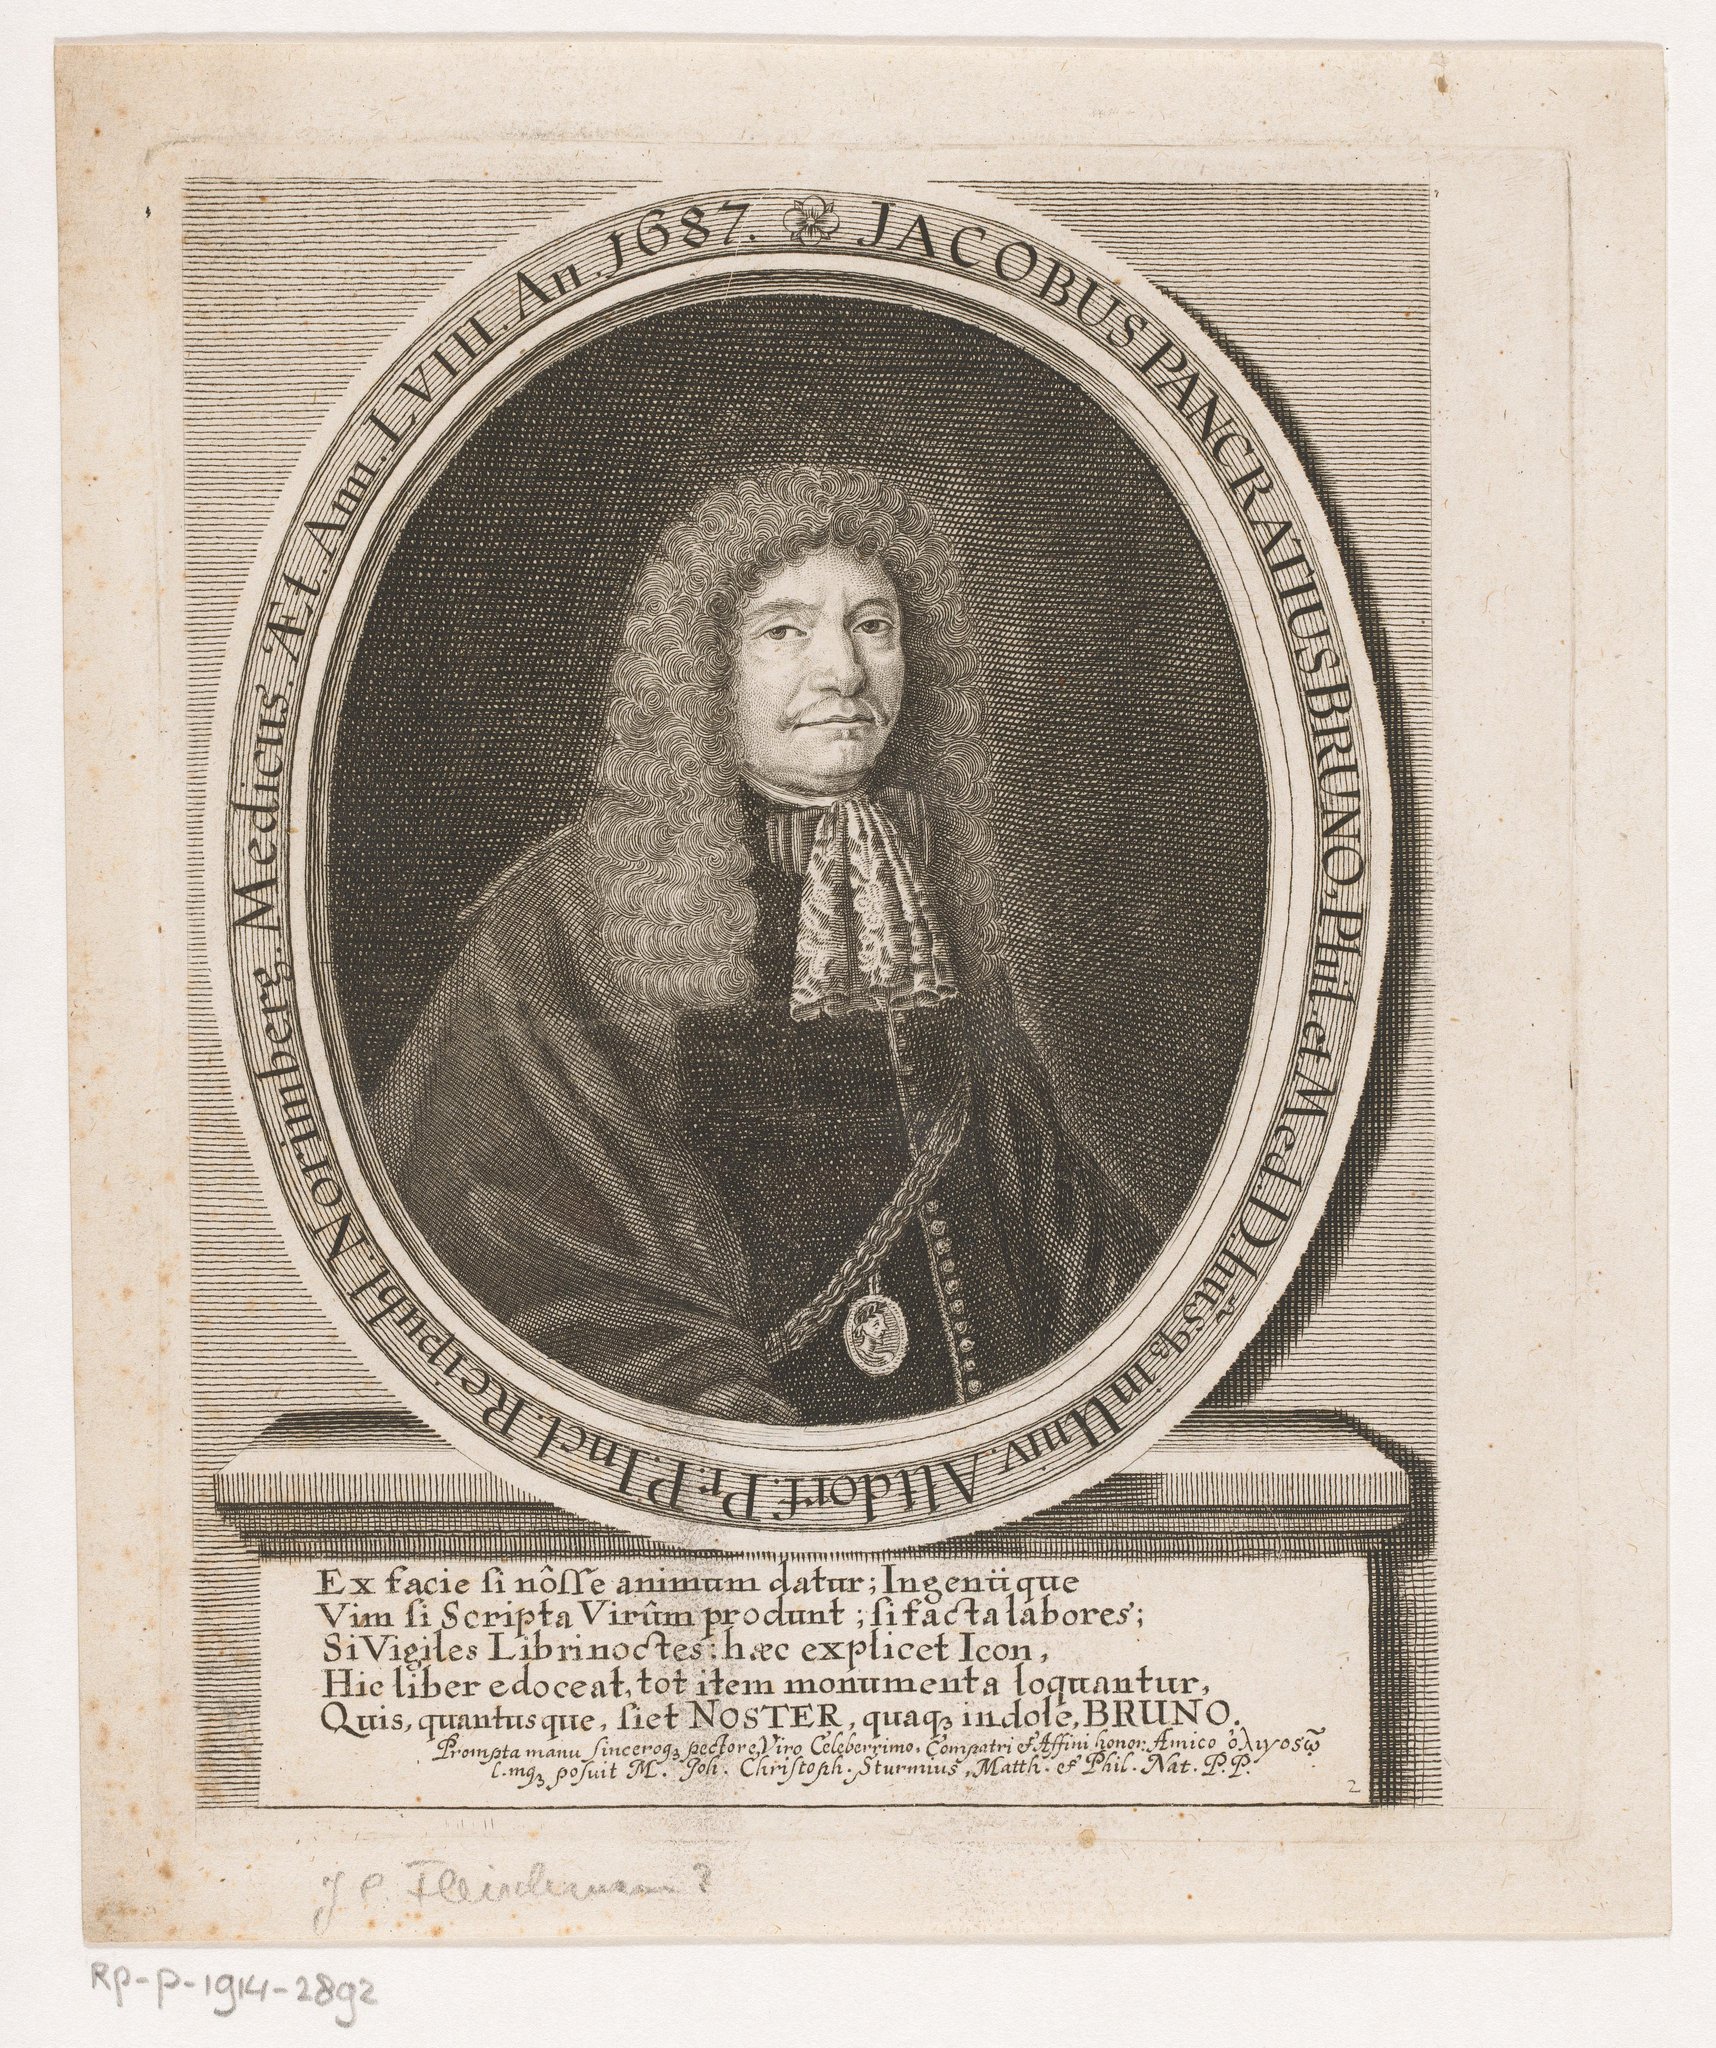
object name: print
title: Portret van Jacob Pancratius Bruno op 58-jarige leeftijd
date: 1687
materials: paper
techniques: engraving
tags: historical persons, pendant, trinket, 'breloque'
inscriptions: collector's mark: Lugt 2228